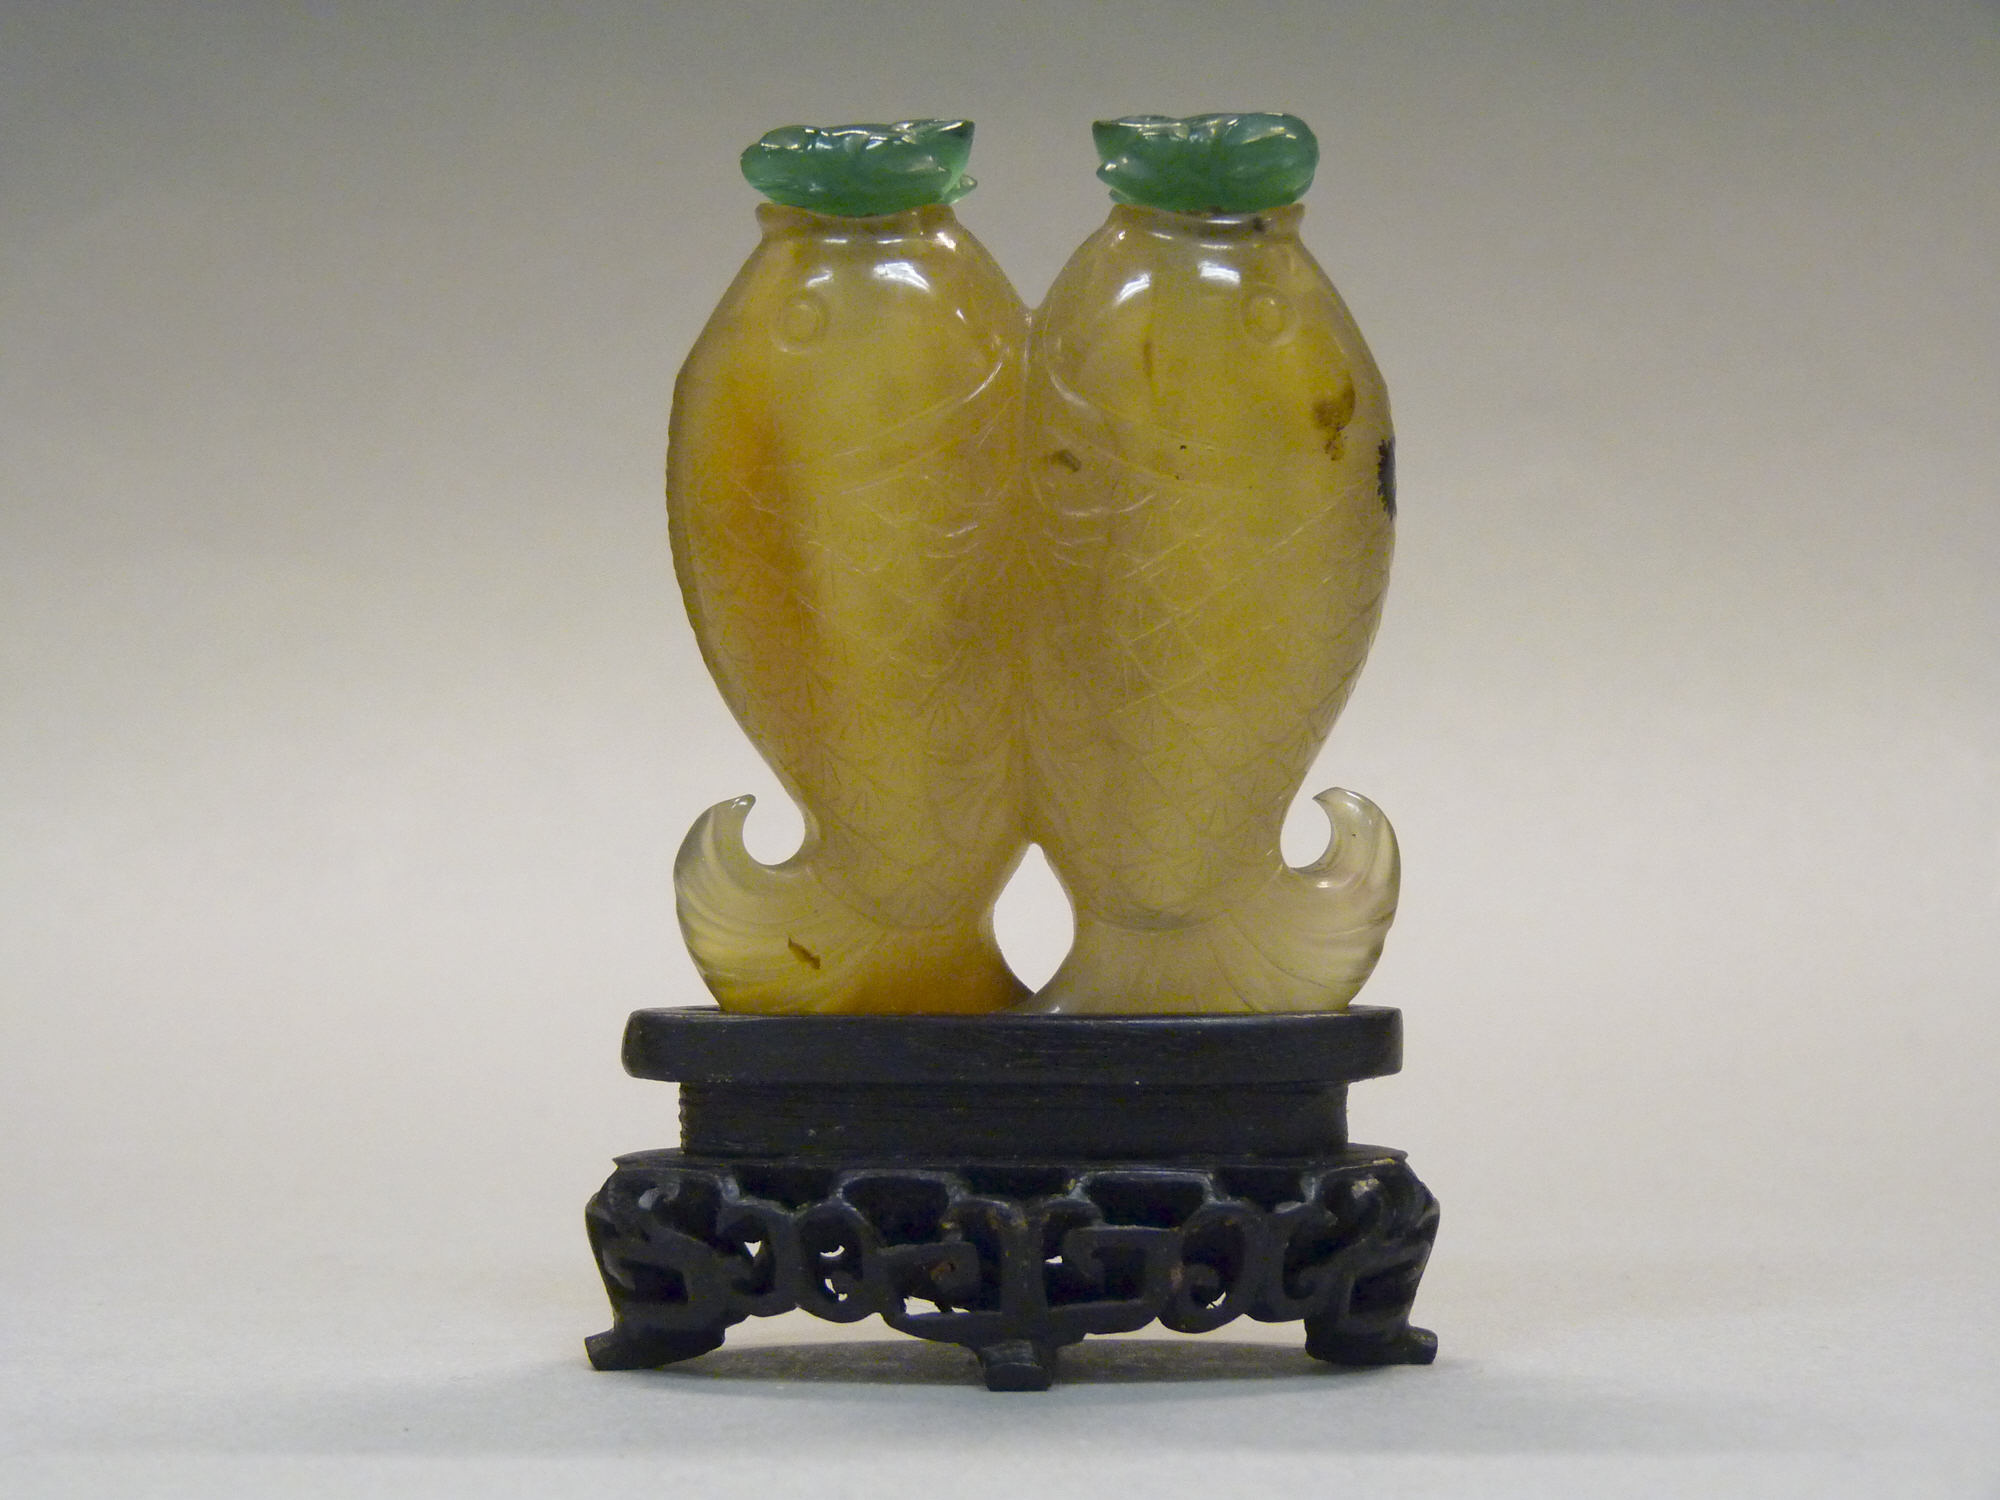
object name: double snuff bottle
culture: chinese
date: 1736-1795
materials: stone, jade, wood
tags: fish